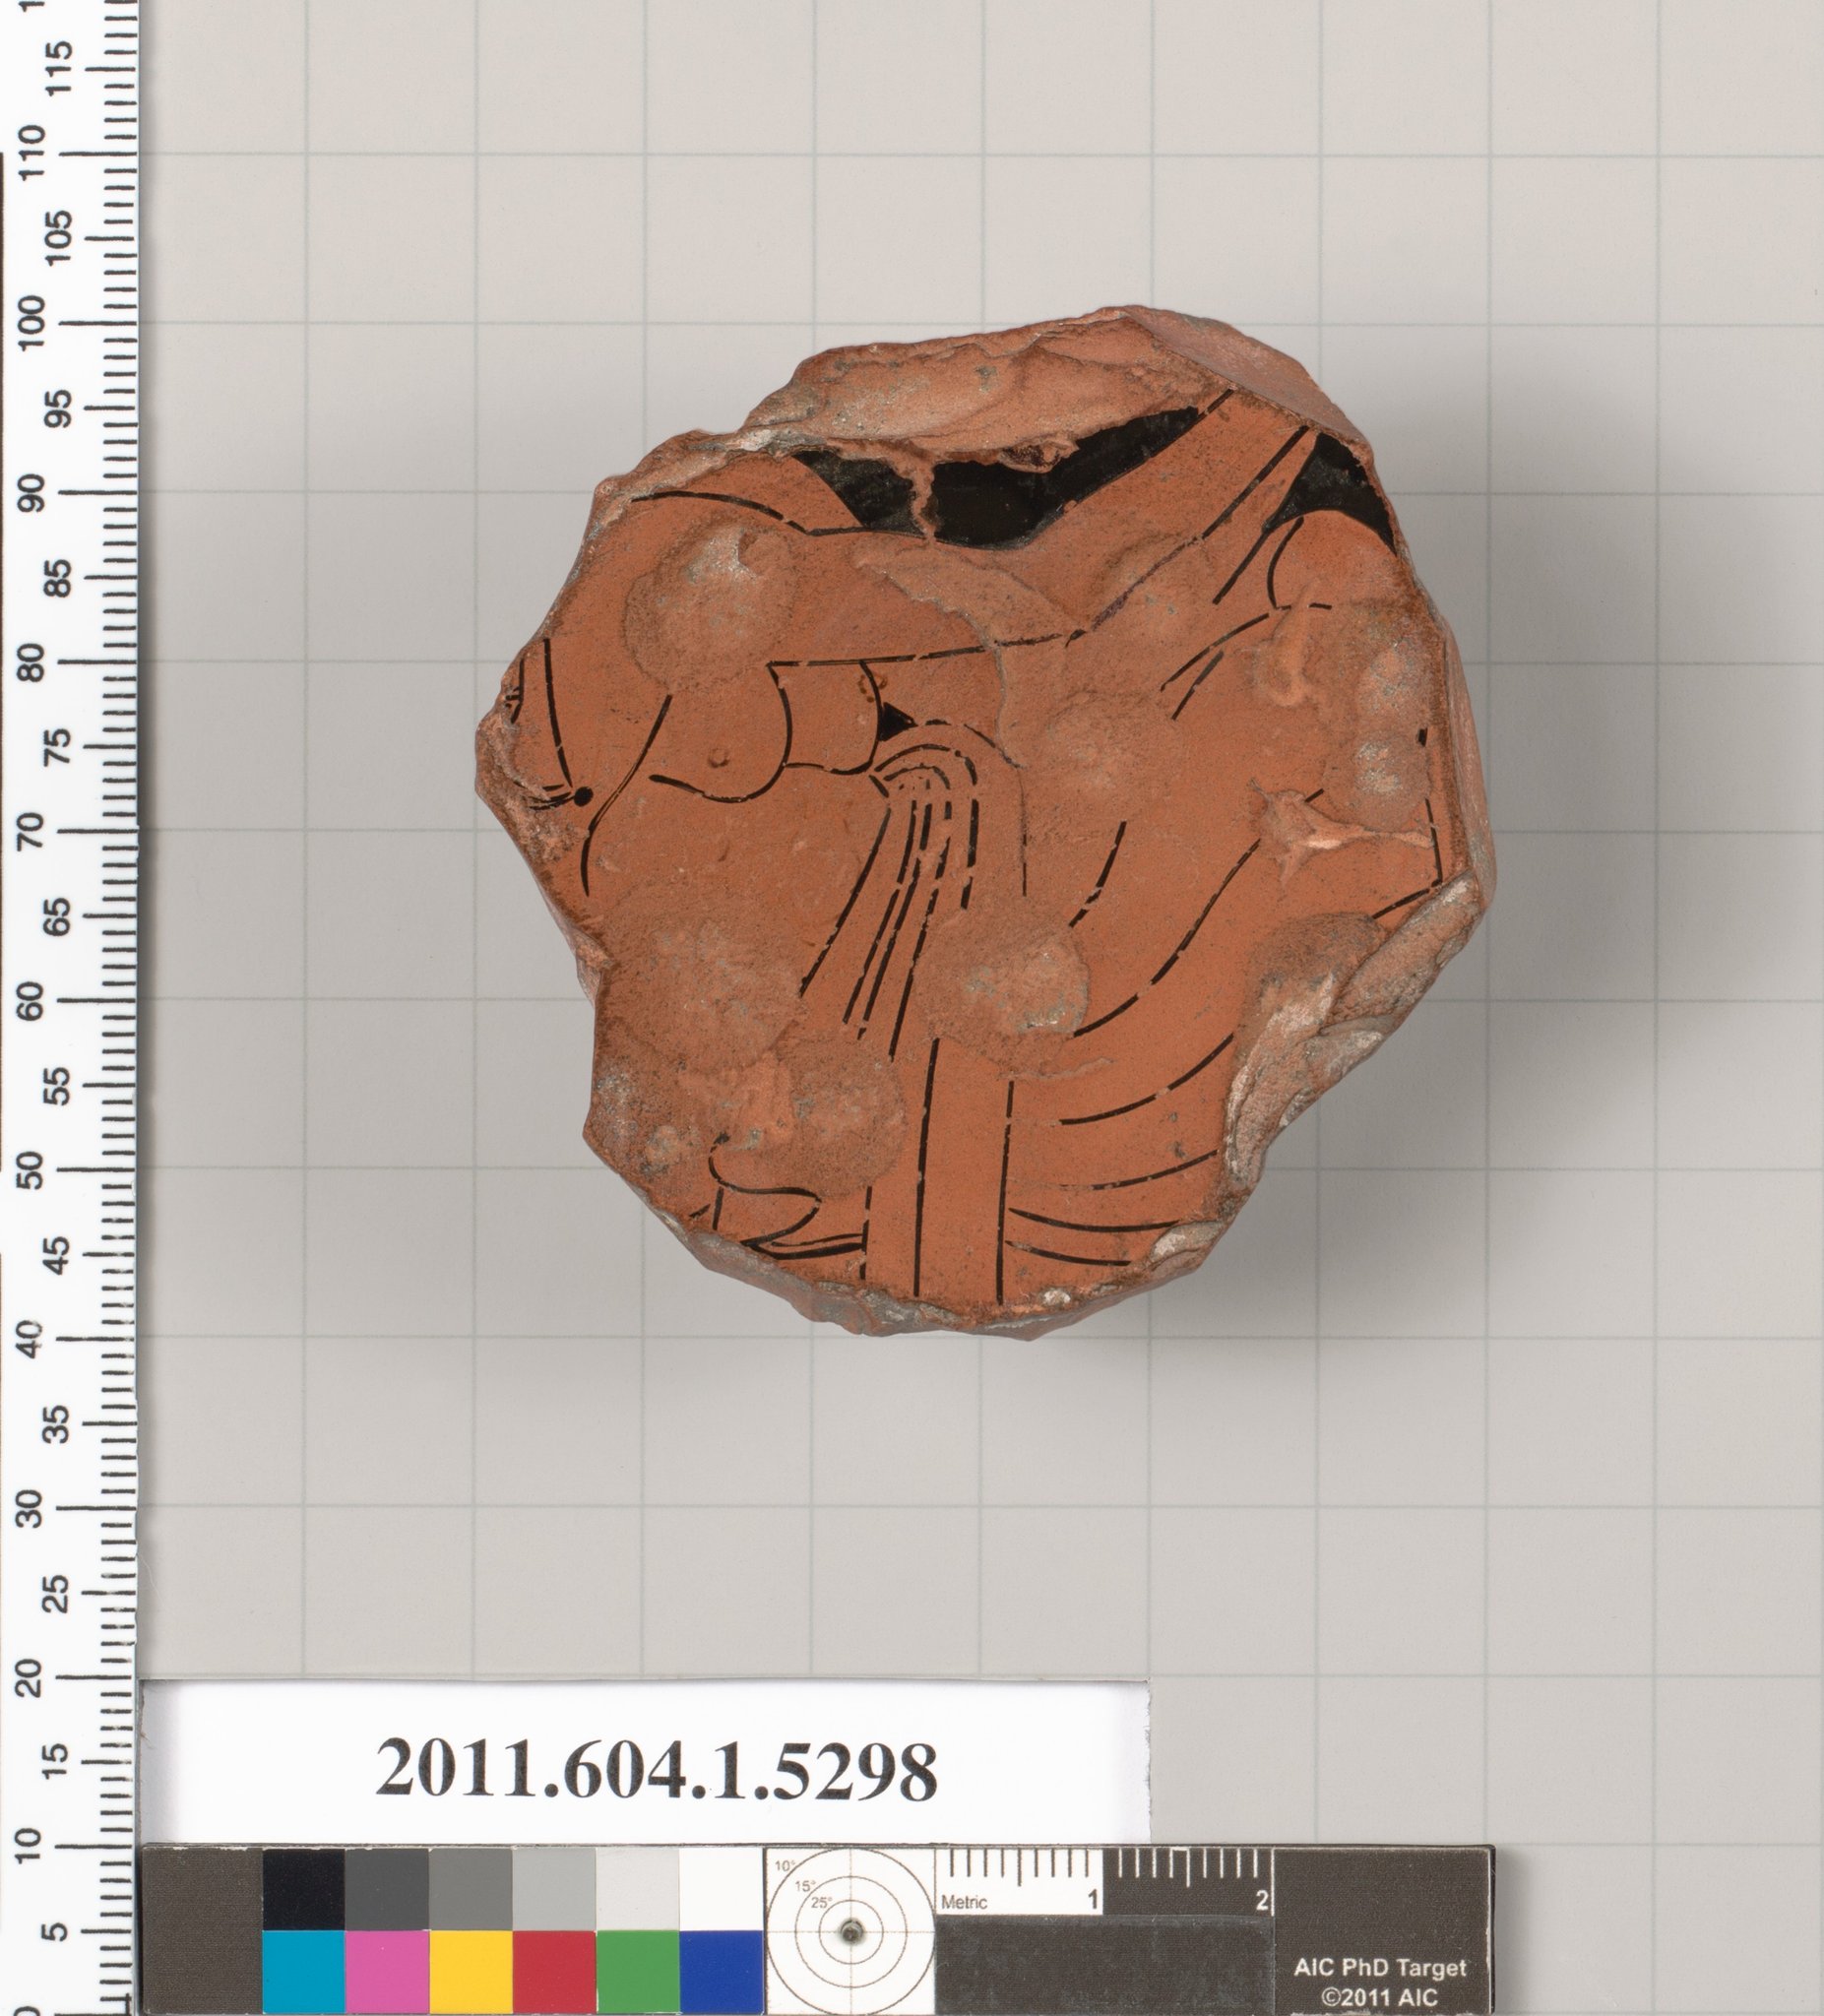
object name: kylix fragment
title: Terracotta fragment of a kylix (drinking cup)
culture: greek, attic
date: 490-480 BCE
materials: terracotta